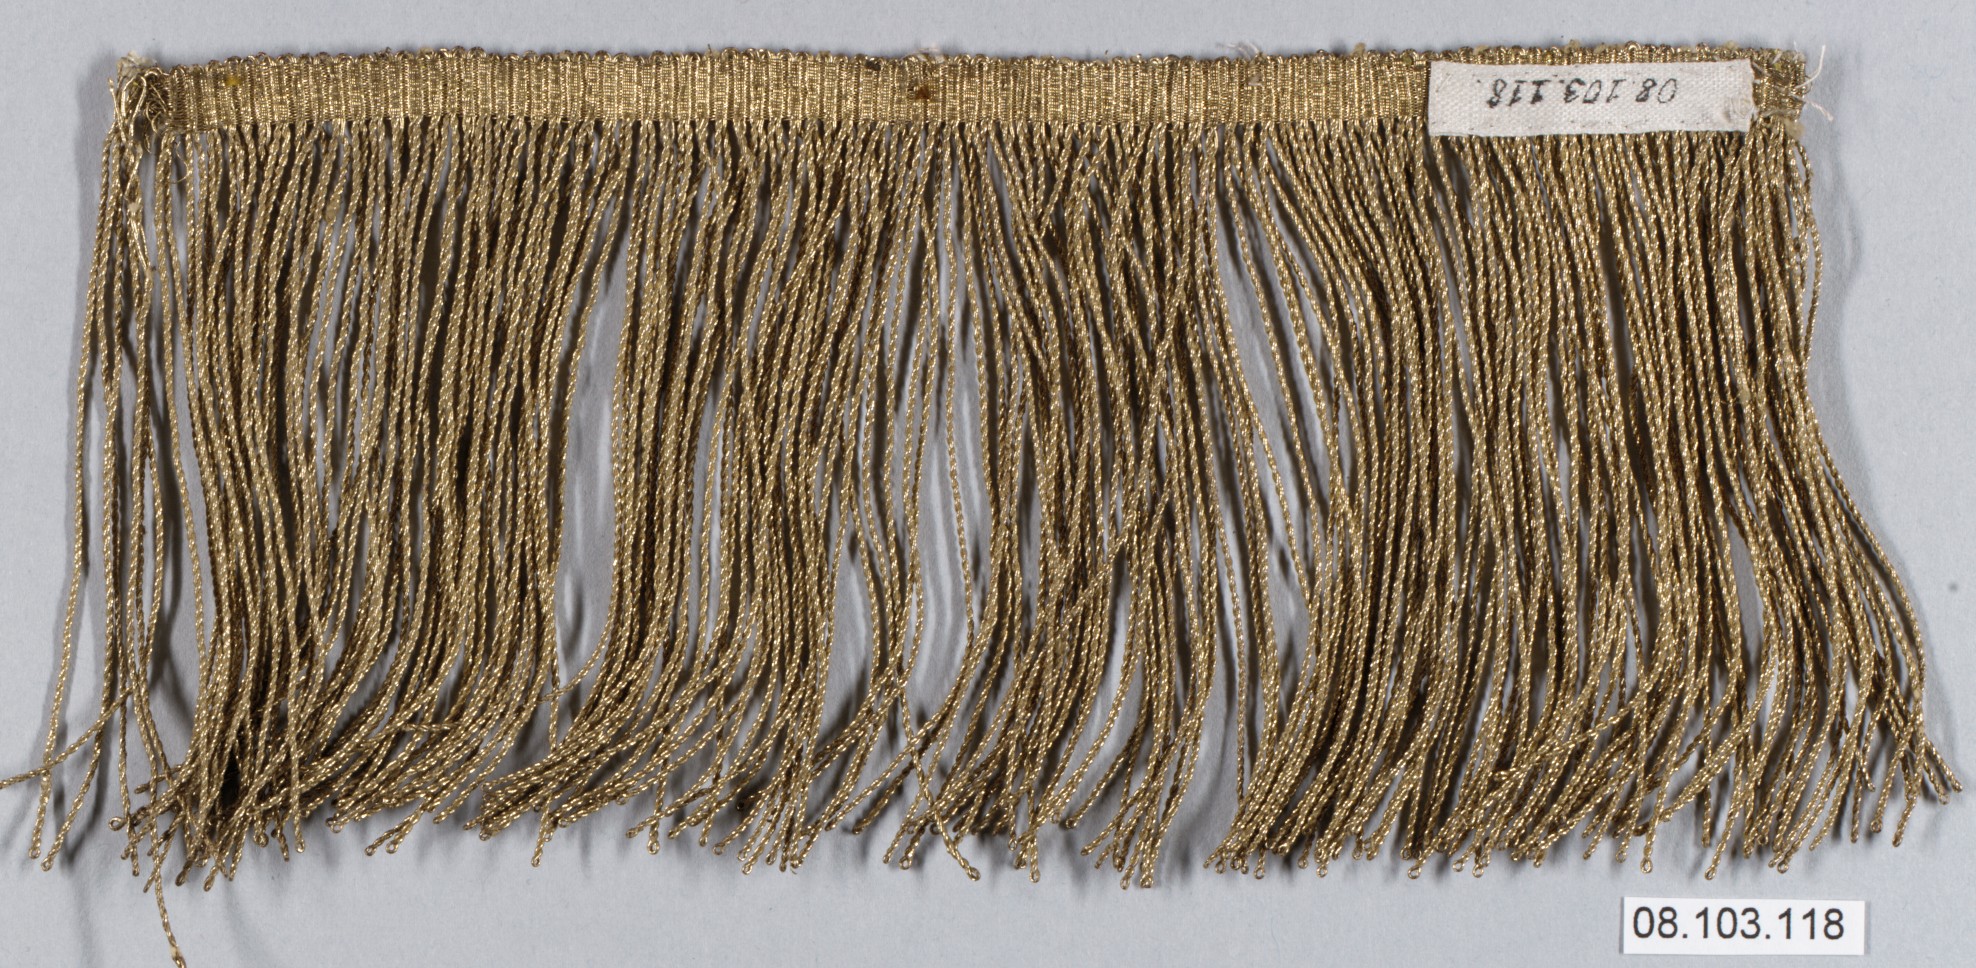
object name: fringe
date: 1801-1833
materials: metal thread